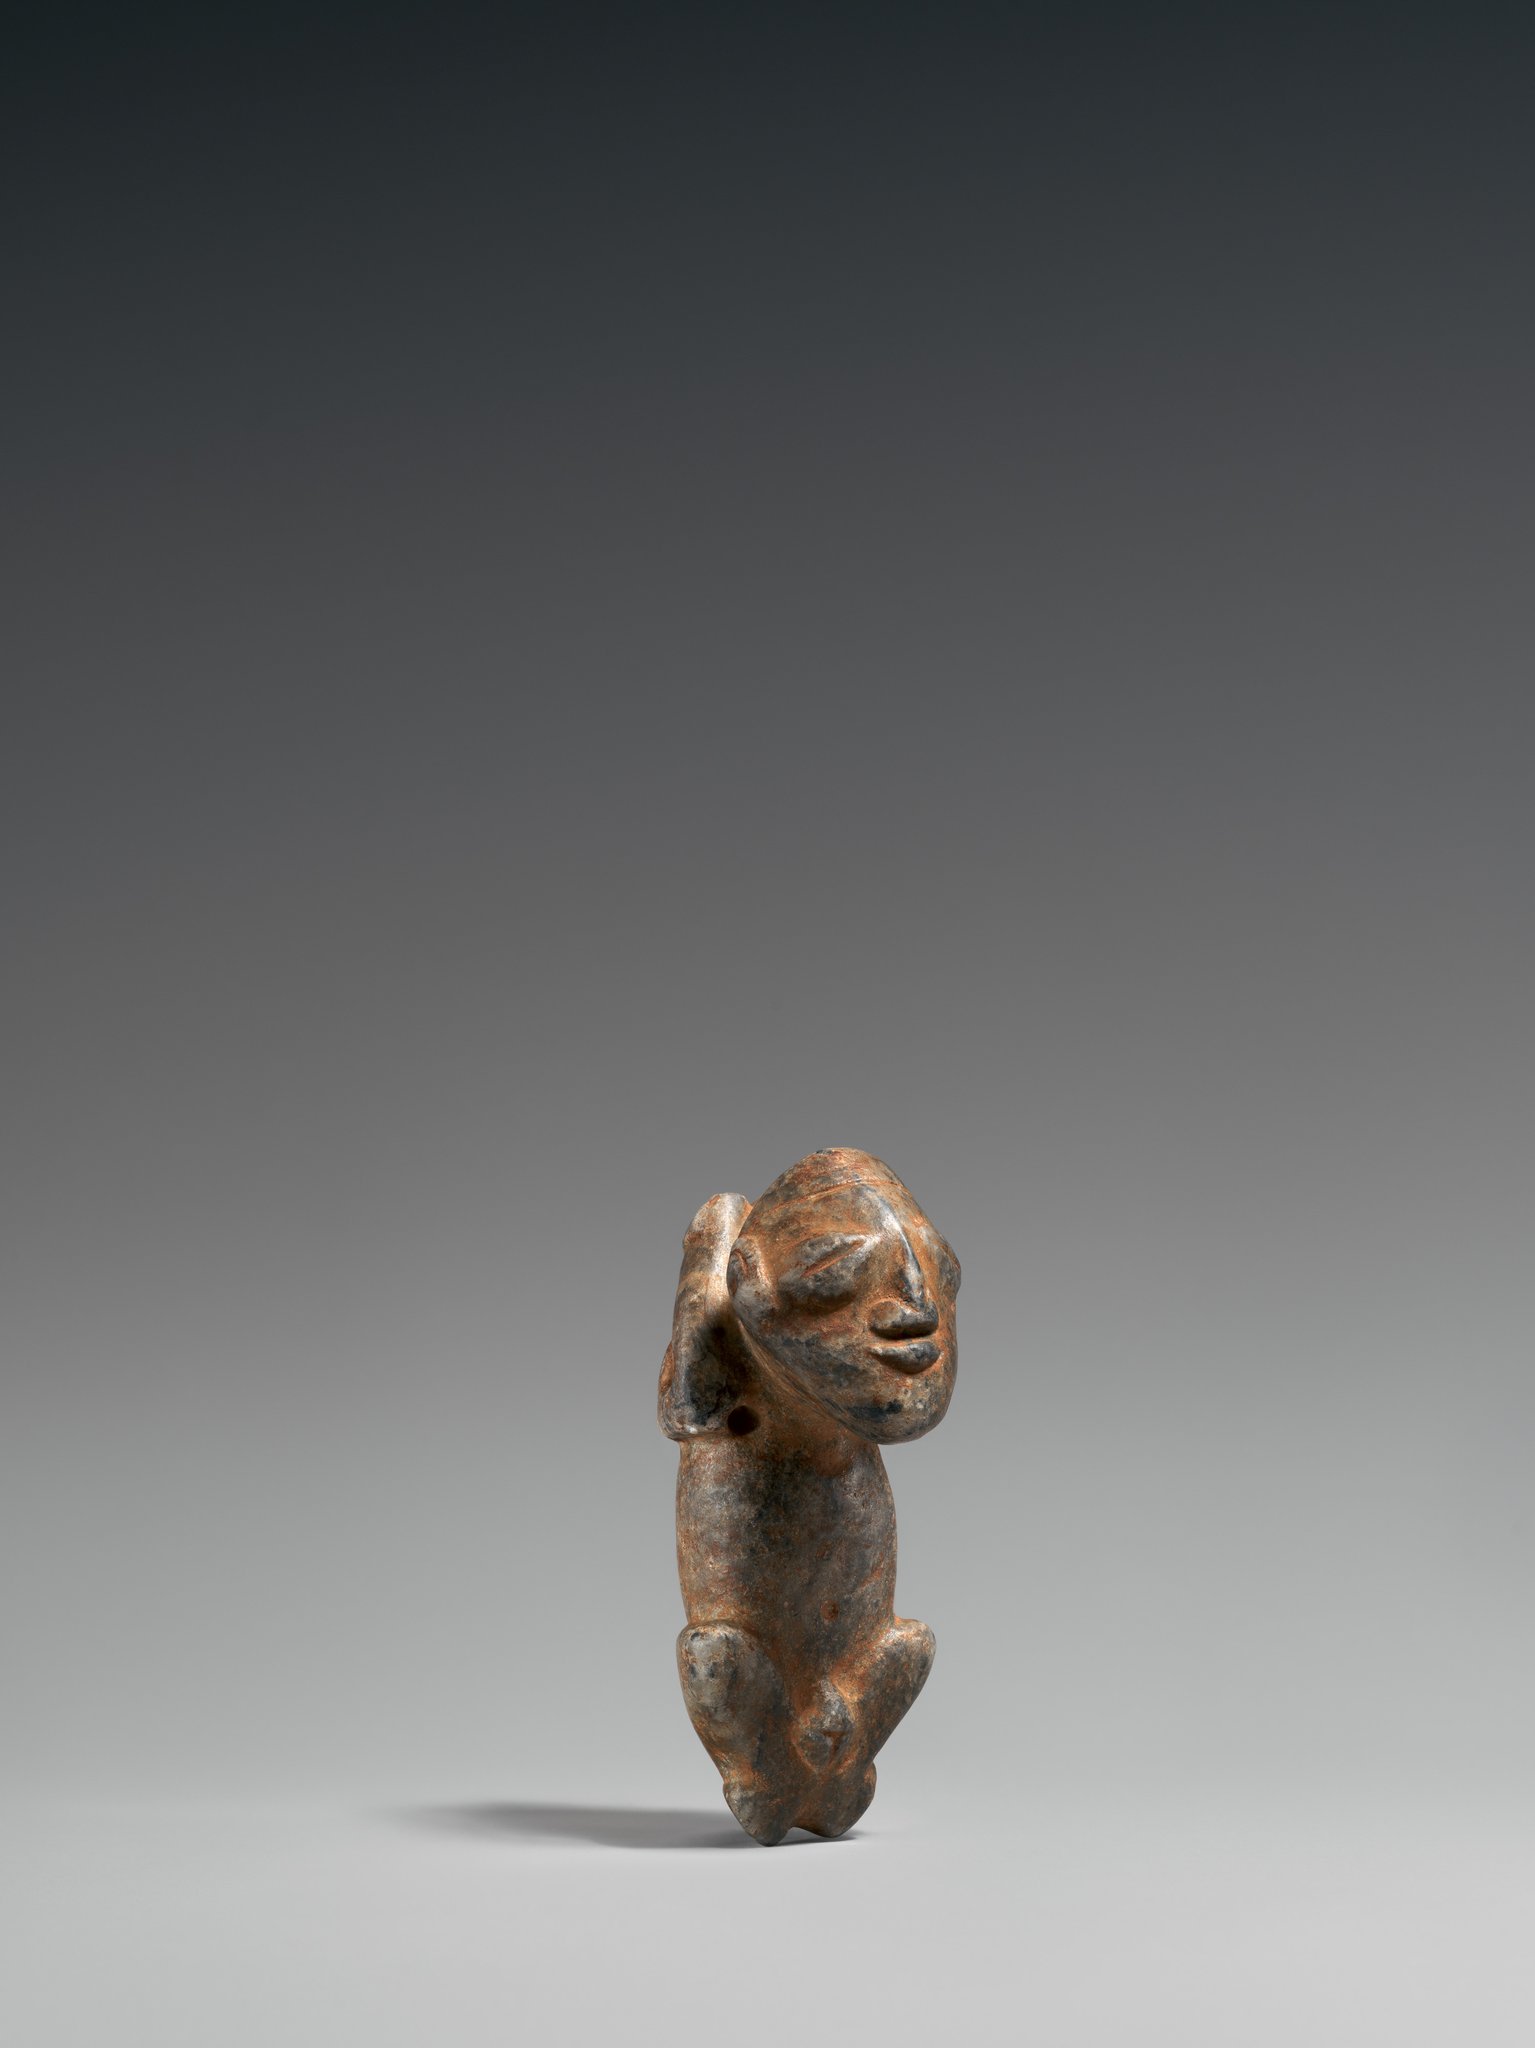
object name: pendant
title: Figure Pendant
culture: taíno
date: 1201-1500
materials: stone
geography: dominican republic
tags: human figures